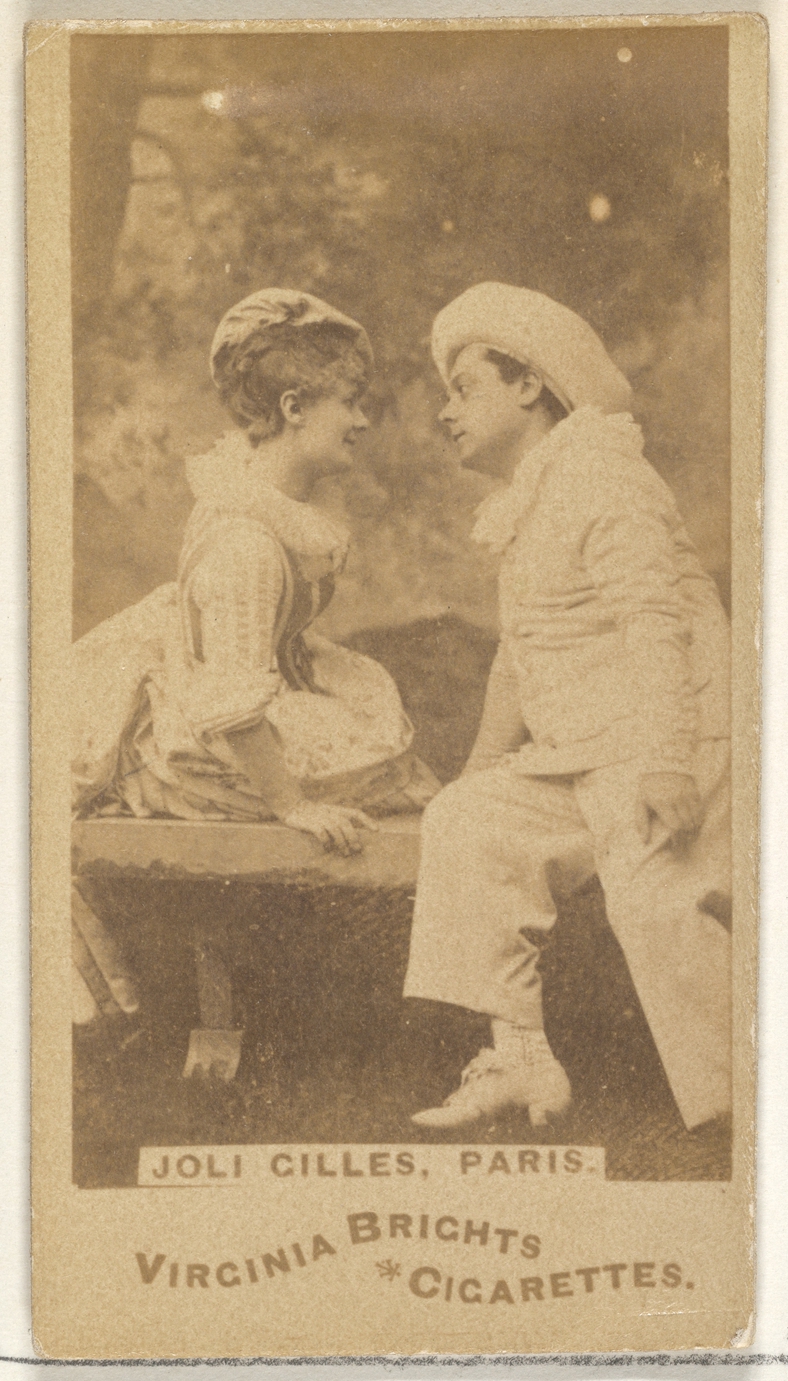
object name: photograph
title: Joli Gilles, Paris, from the Actors and Actresses series (N45, Type 1) for Virginia Brights Cigarettes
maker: allen & ginter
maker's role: publisher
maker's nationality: american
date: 1888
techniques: albumen silver print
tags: men,women,actresses